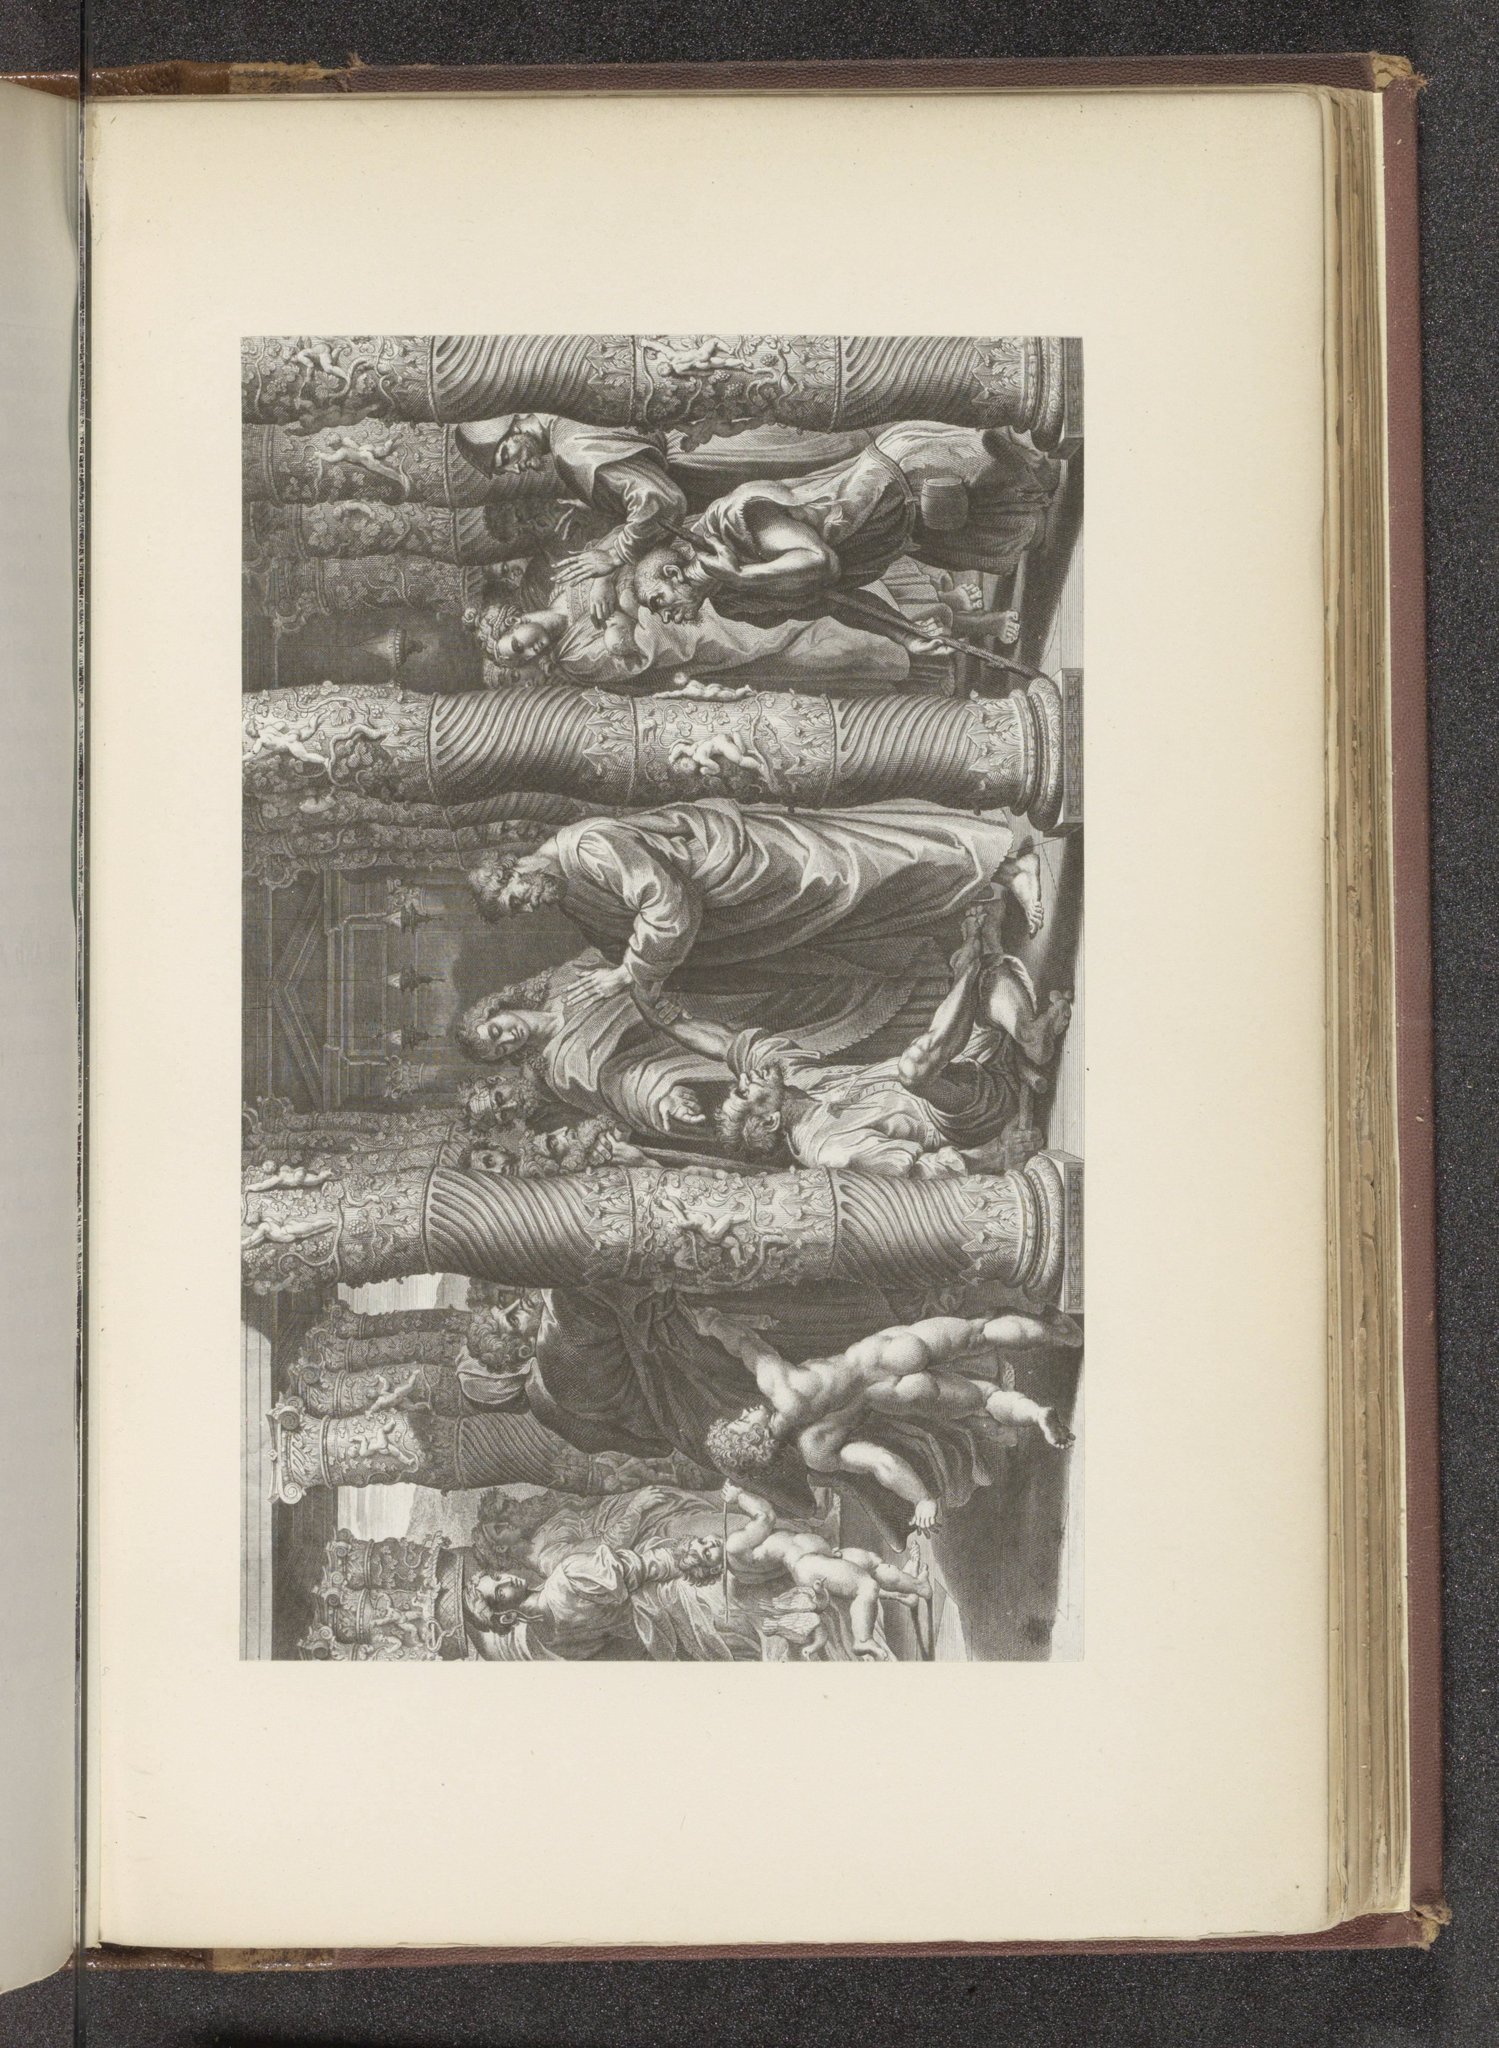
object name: photomechanical print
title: Fotoreproductie van een prent, met de voorstelling van Petrus en Johannes die een verlamde man genezen bij de tempelpoort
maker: Anonymous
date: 1872-1882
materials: paper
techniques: woodburytype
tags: healing of a lame beggar at the beautiful gate of the temple by peter and john (acts 3 - 4:31)